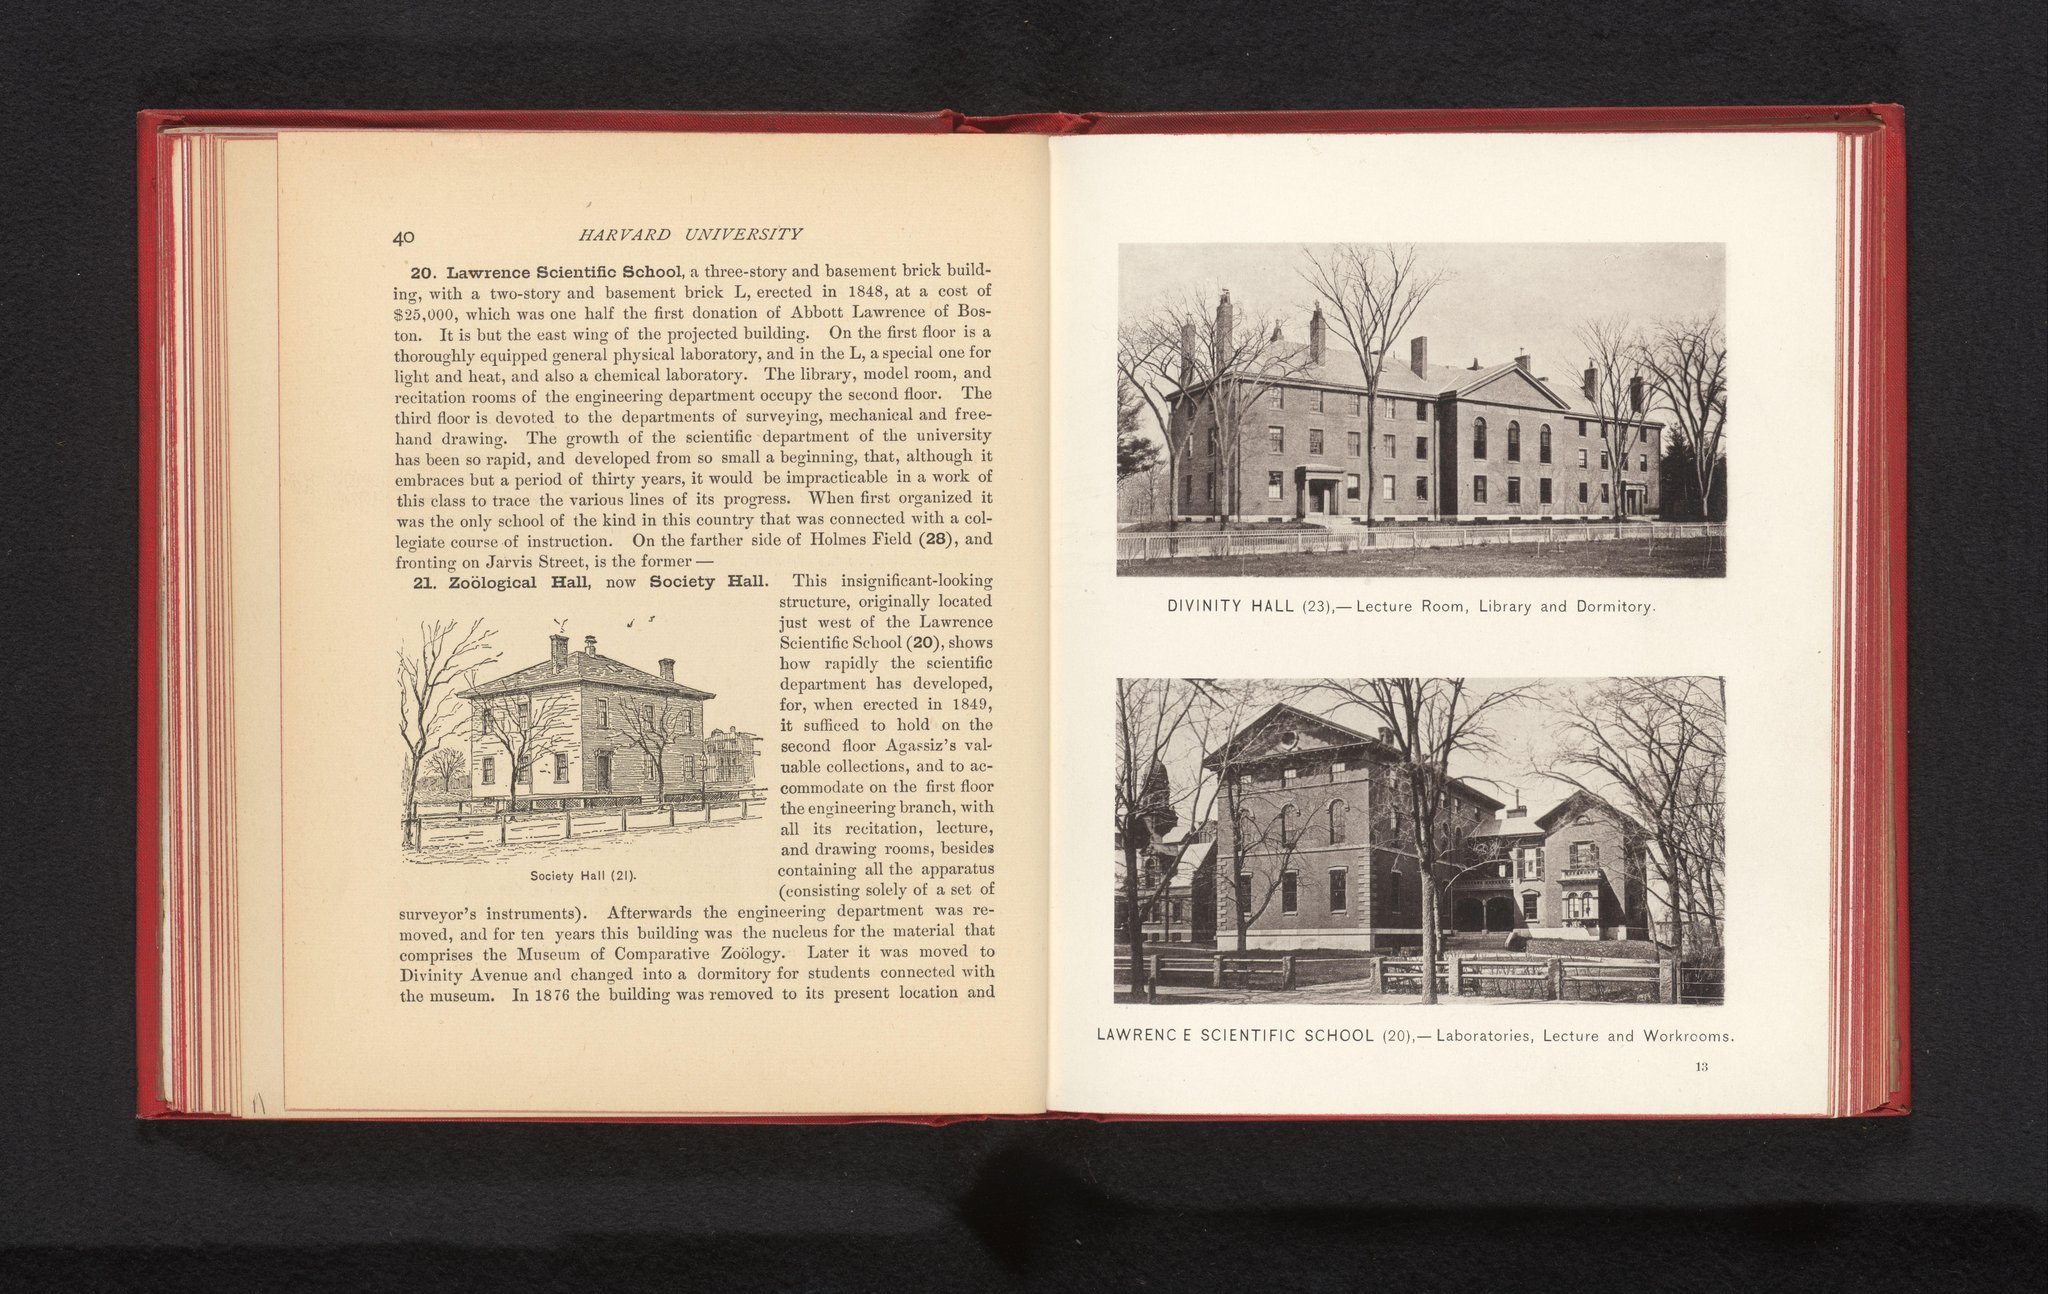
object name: page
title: Lawrence E Scientific School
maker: Anonymous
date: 1881-1886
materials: paper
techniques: photograph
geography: cambridge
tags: university building, college, façade (of house or building)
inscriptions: number: ‘(23) (20)’